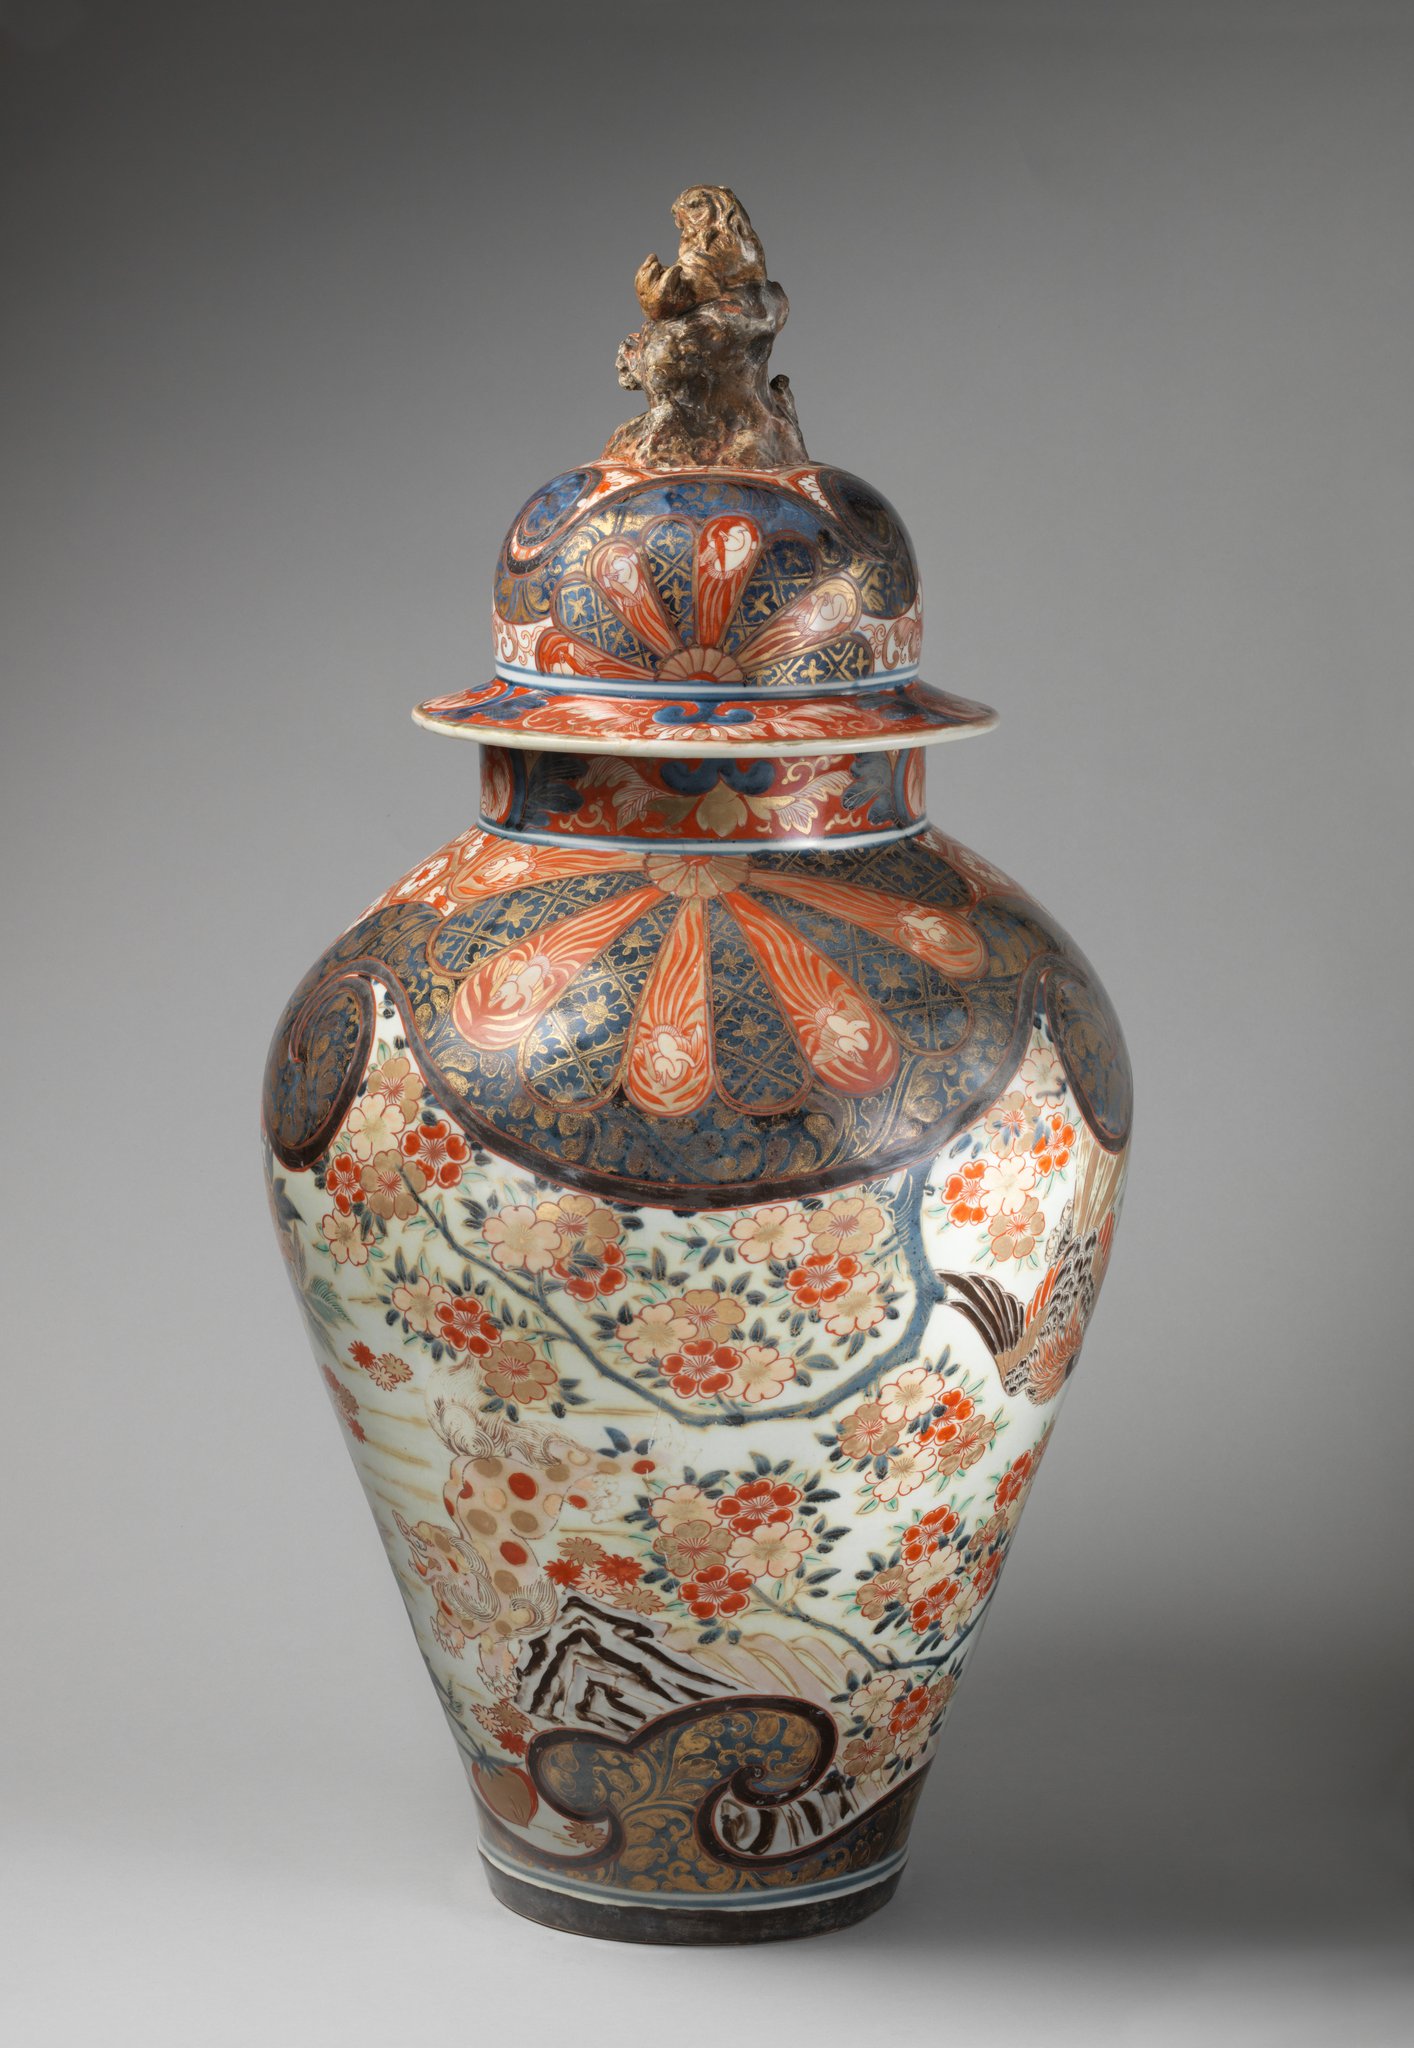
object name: vase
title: Baluster-shaped vase (part of an assembled garniture)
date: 1690-1720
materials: enamel, hard paste porcelain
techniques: gilding, overglaze, underglaze